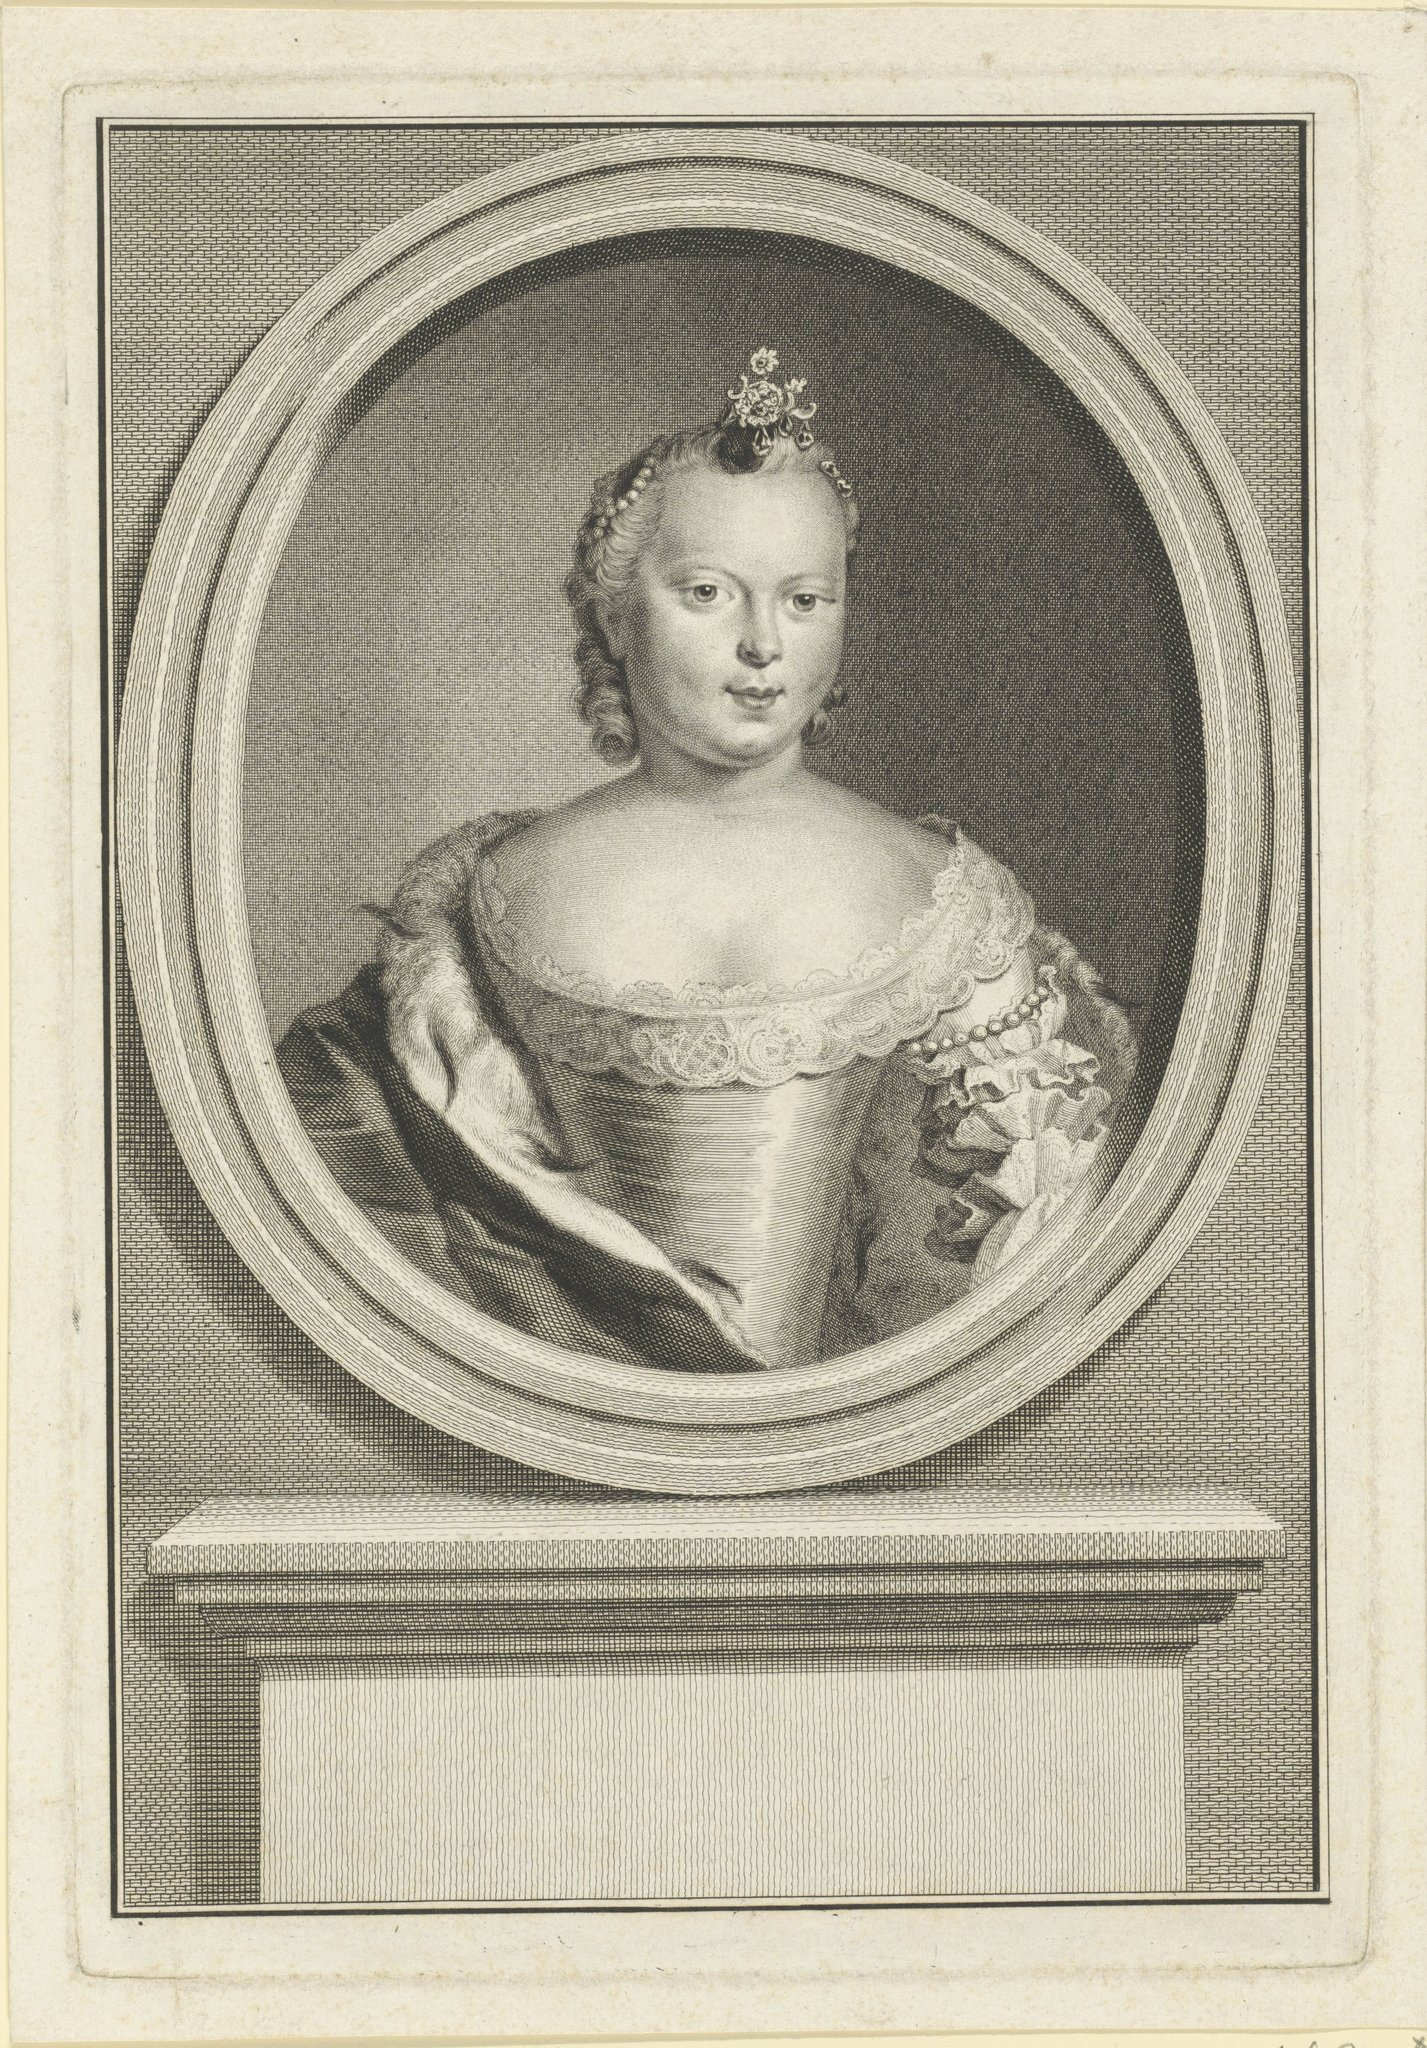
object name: print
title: Portret van Carolina, prinses van Oranje-Nassau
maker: jacob houbraken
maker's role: draughtsman, print maker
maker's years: 1698-1780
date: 1750-1780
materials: paper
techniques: engraving, etching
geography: amsterdam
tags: carolina (prinses van oranje-nassau)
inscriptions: collector's mark: Lugt 2228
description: De hier vermelde titel verwijst naar de hoogst verkregen titel van de geportretteerde, niet per se naar de titel die de geportretteerde op deze voorstelling draagt.